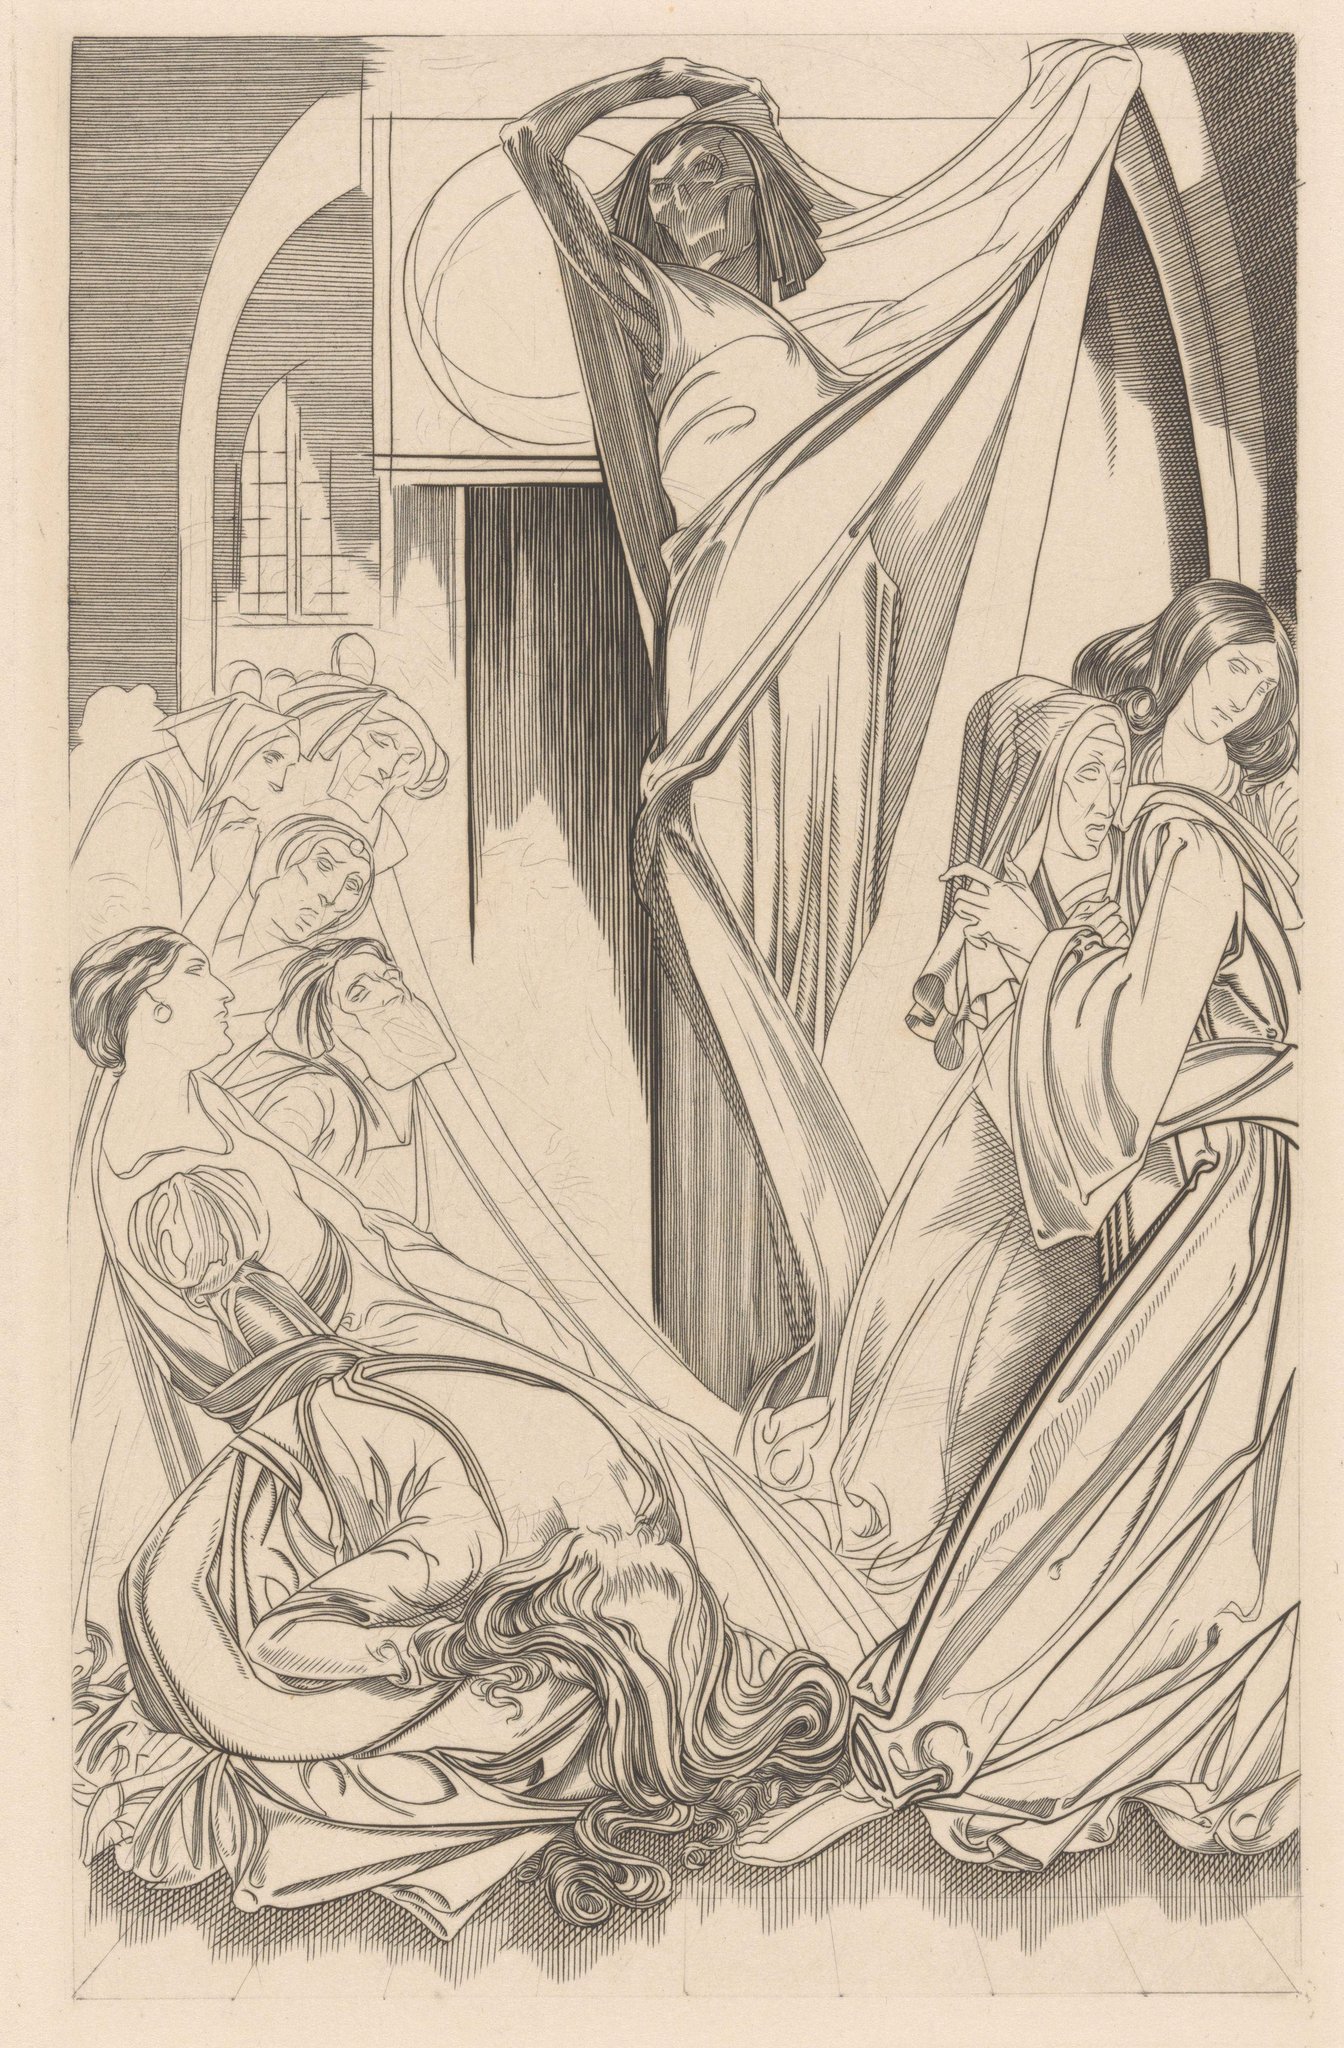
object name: print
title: De Dood met een groep vrouwen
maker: johannes josephus aarts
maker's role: draughtsman, print maker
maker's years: 1871-1934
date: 1881-1934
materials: paper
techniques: engraving, intaglio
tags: kneeling figure - aa - female human figure, personifications of death; 'morte' (ripa) - ff - death as female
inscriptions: collector's mark: Lugt 2166, collector's mark: Lugt 2760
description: De Dood, gekleed in een gewaad, torent boven een groep vrouwen uit. Links op de voorgrond ligt een vrouw geknield op de grond.